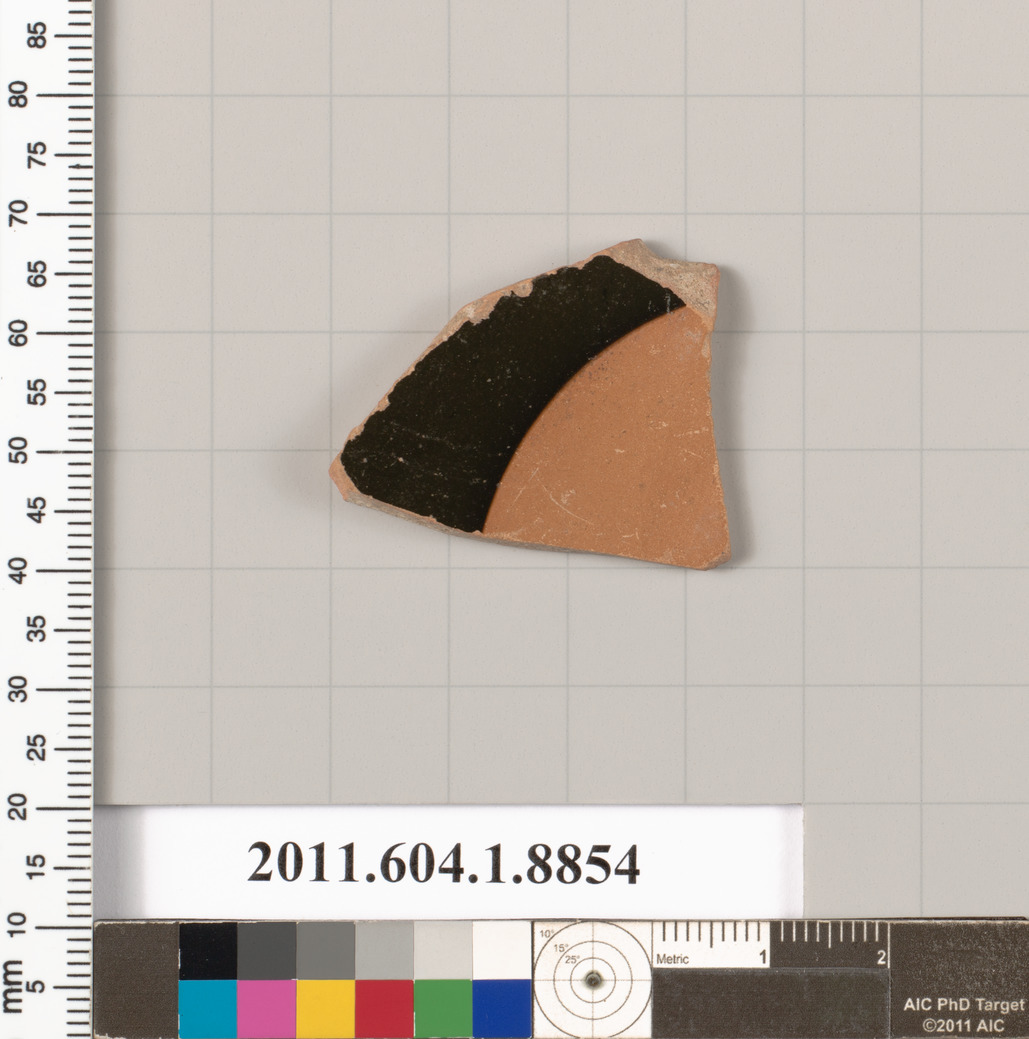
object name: kylix fragment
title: Terracotta fragment of a kylix (drinking cup)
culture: greek, attic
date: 500-480 BCE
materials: terracotta